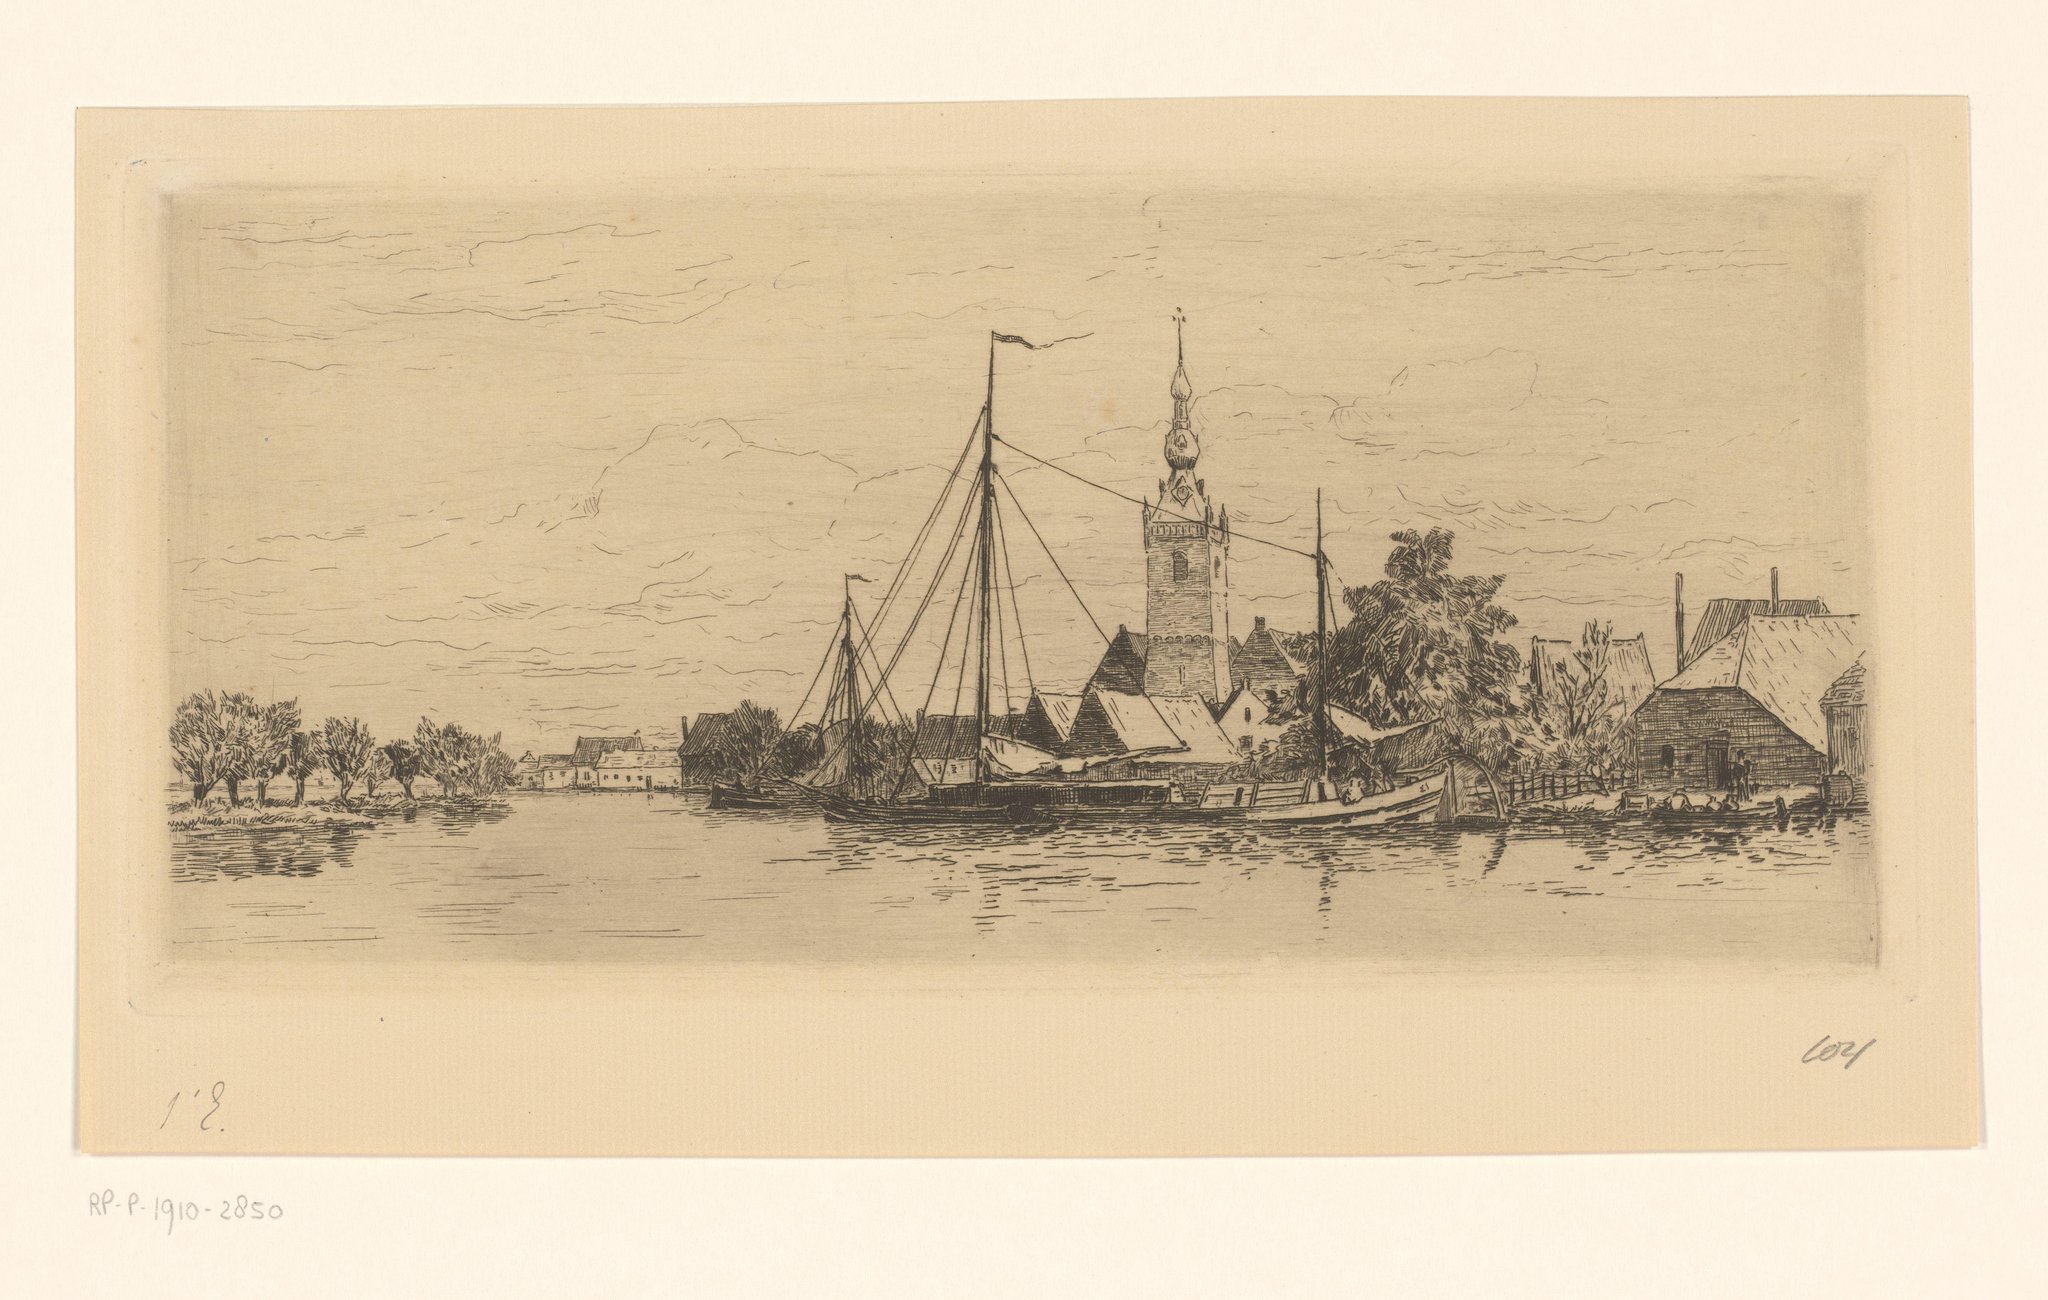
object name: print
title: La Hollande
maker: carel nicolaas storm van s-gravesande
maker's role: draughtsman, print maker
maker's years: 1841-1924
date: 1877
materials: paper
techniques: etching, intaglio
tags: canals, waters (in village), parts of church exterior and annexes: tower, overschie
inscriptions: collector's mark: Lugt 2228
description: Dorpsgezicht aan het water. In het midden de toren van de Nederlands Hervormde Kerk.